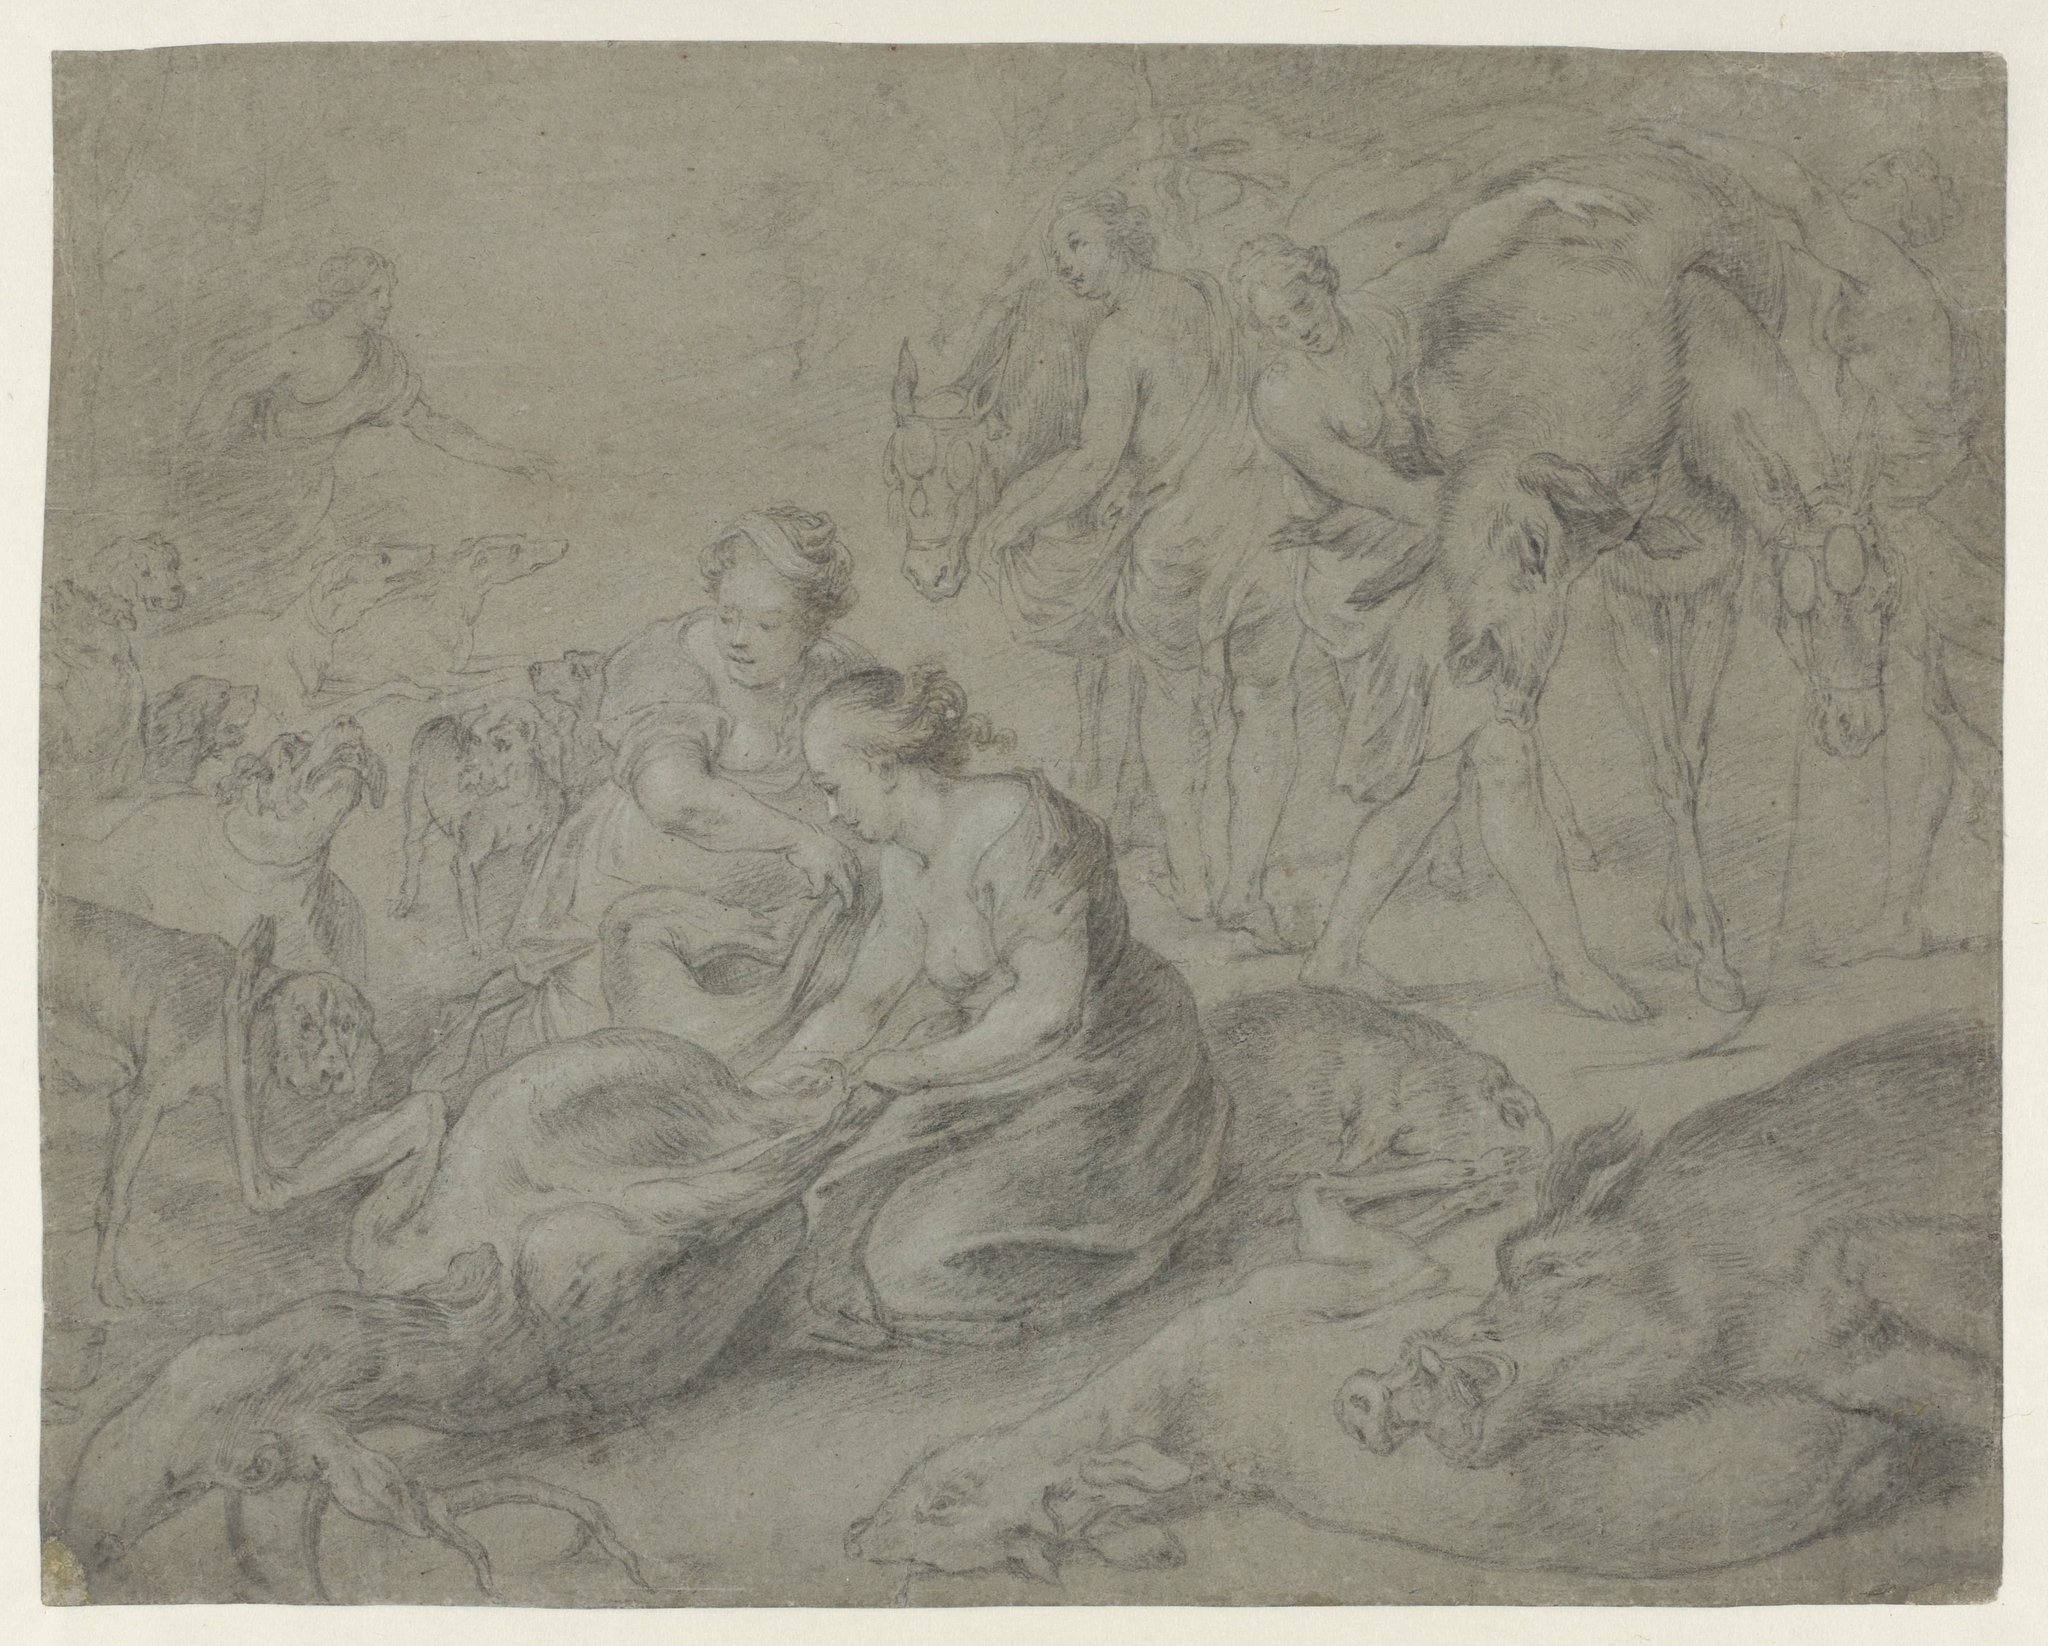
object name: drawing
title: Diana en haar nimfen na de jacht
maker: Anonymous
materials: chalk, paper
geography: southern netherlands